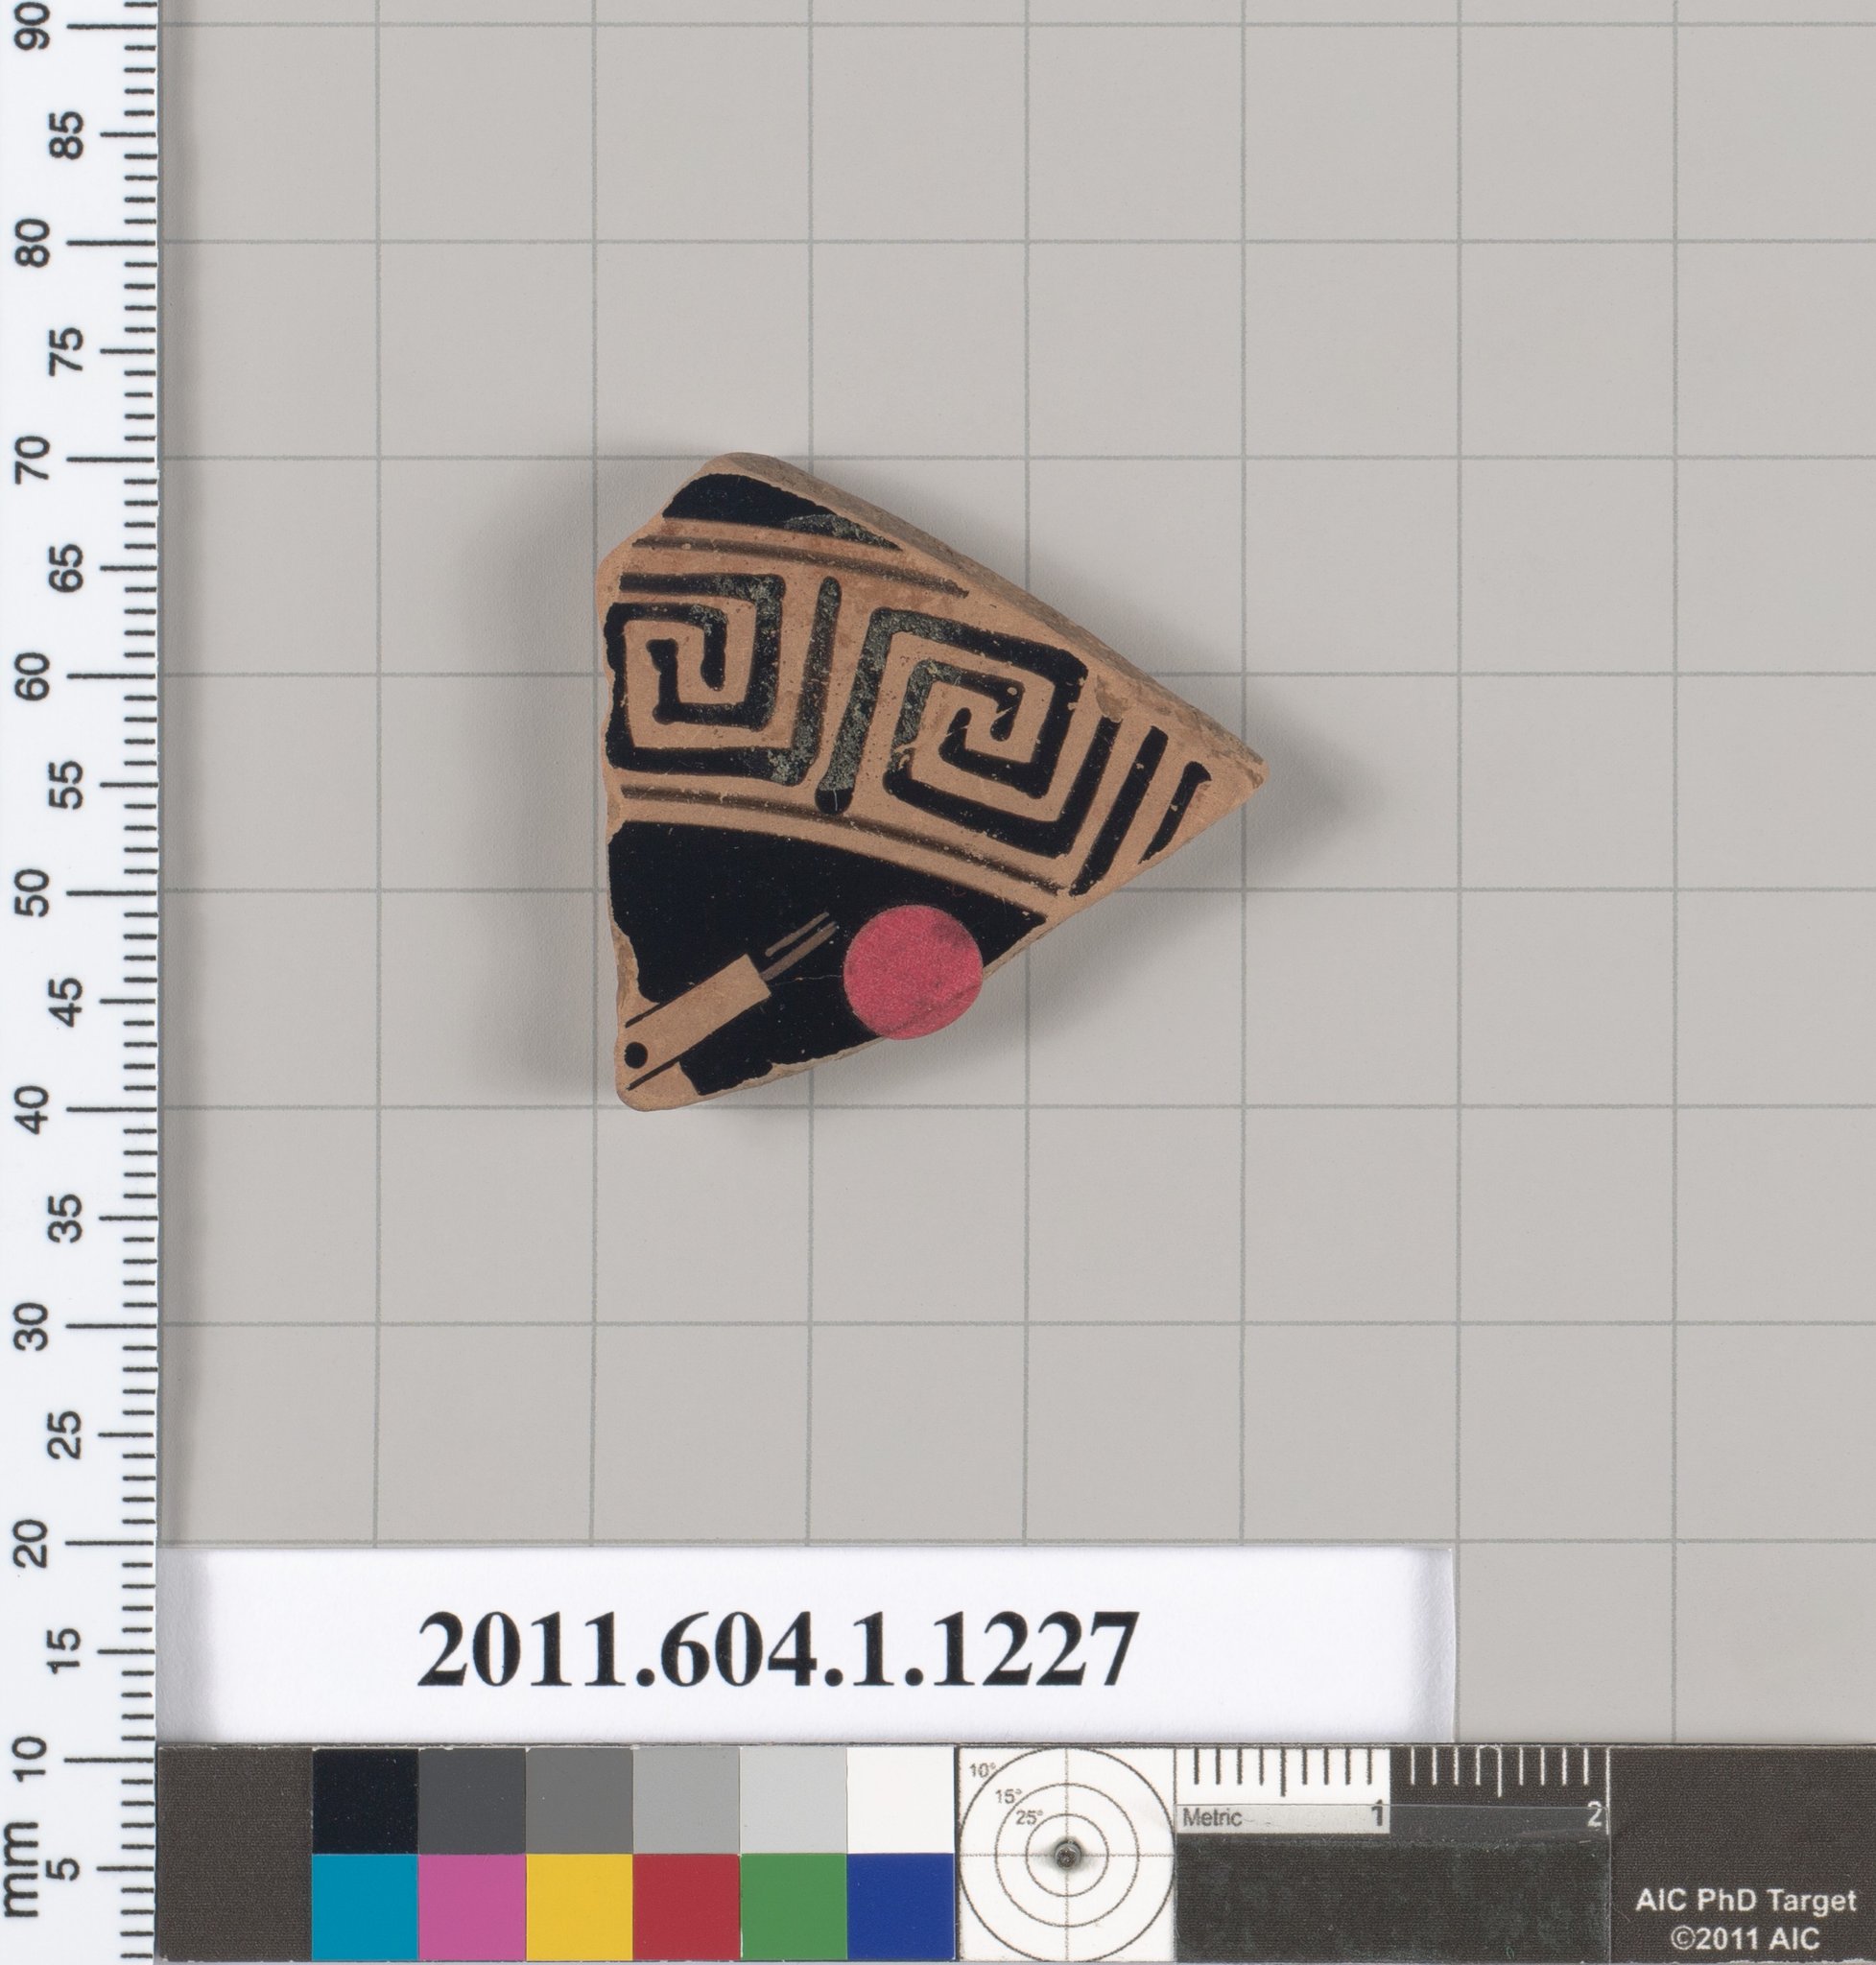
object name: kylix fragment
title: Terracotta fragment of a kylix (drinking cup)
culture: greek, attic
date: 475-451 BCE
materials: terracotta